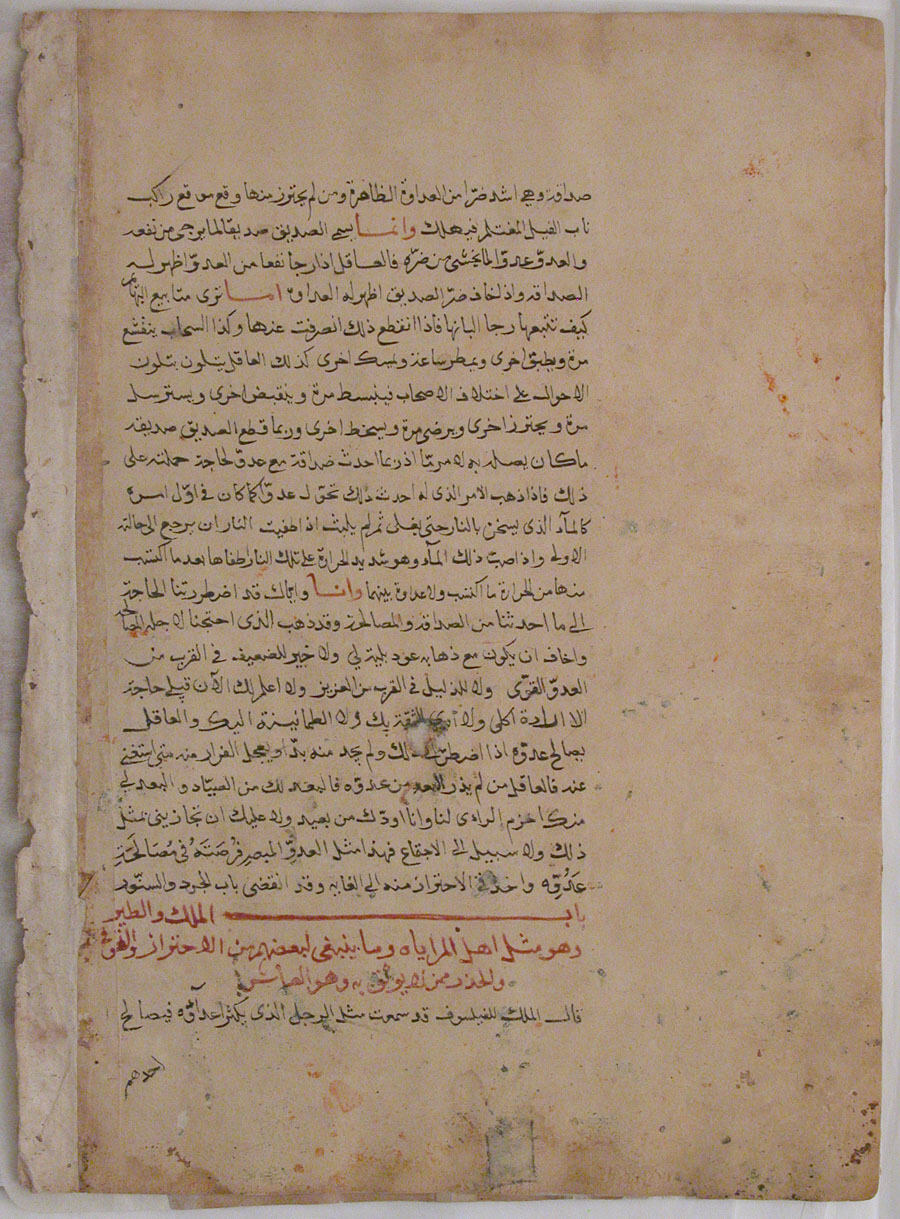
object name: folio from an illustrated manuscript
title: Page of Calligraphy from a Kalila wa Dimna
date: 1526-1550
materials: ink, paper, watercolor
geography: india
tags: arabic,calligraphy